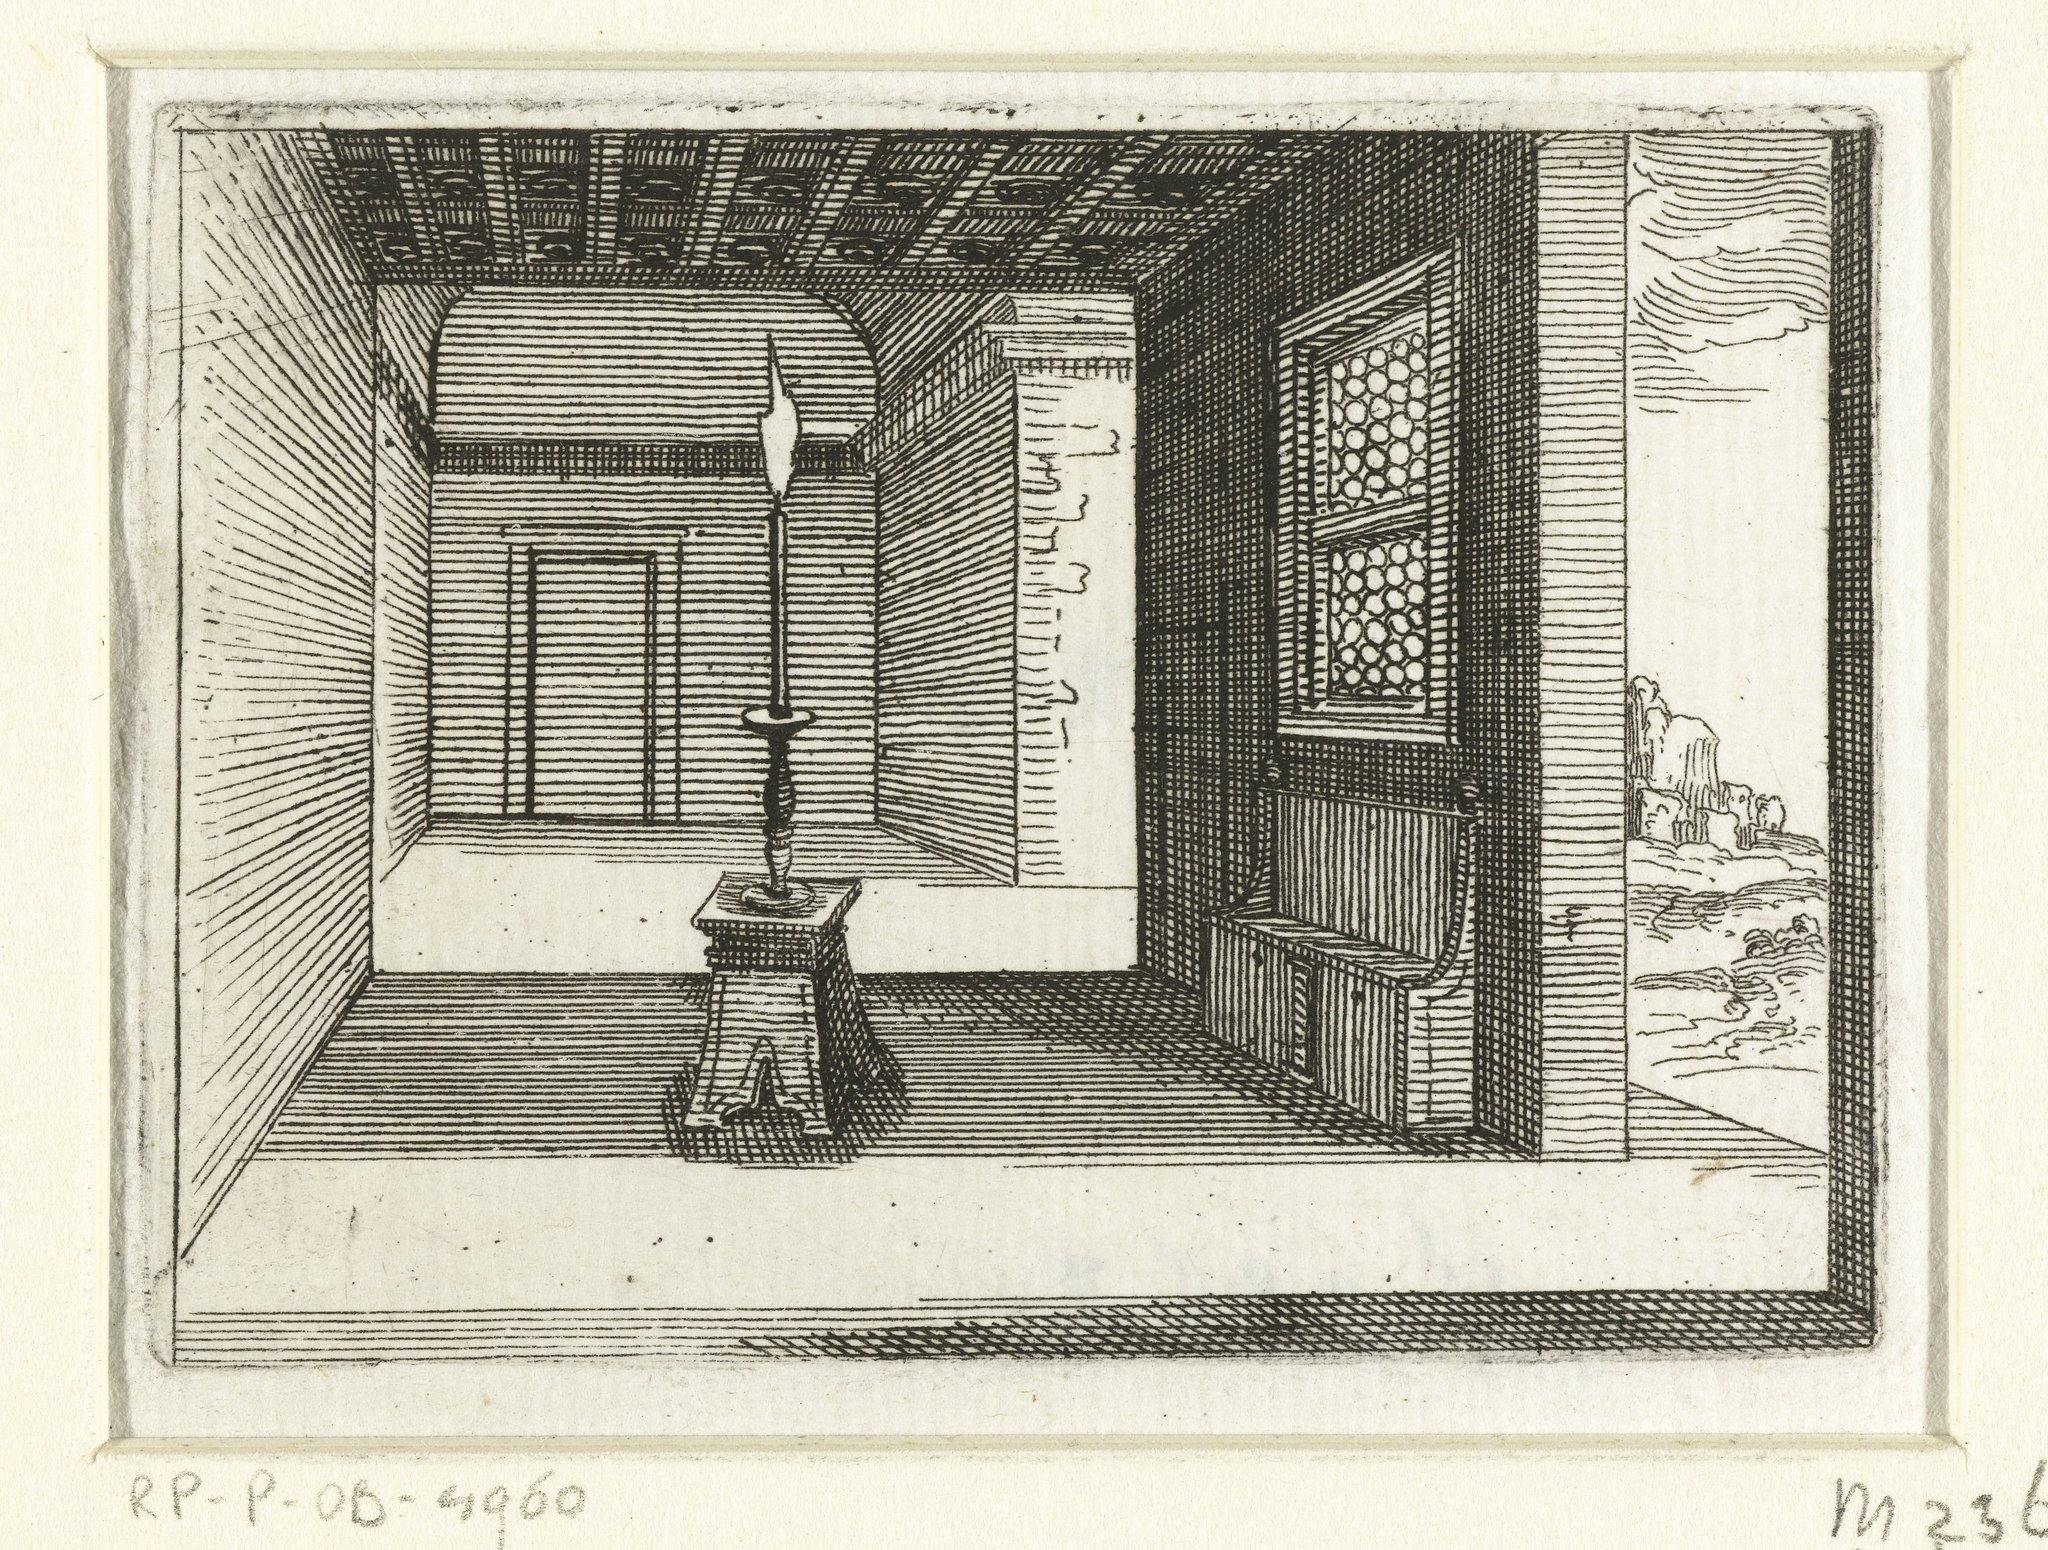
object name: print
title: Brandende kaars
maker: jacques callot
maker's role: draughtsman, print maker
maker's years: 1592-1635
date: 1621-1635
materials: paper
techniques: etching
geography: nancy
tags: candle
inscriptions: collector's mark: Lugt 240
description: Voorstelling van een brandende kaars op een kruk in een leeg vertrek. Dit blad is onderdeel van de embleemserie 'Kloosterleven in emblemen'. De tweede staat van deze serie behelst naast een geïllustreerde titelpagina en 26 emblemen nog een titelpagina en een blad met opdracht, beide in boekdruk zonder afbeelding.